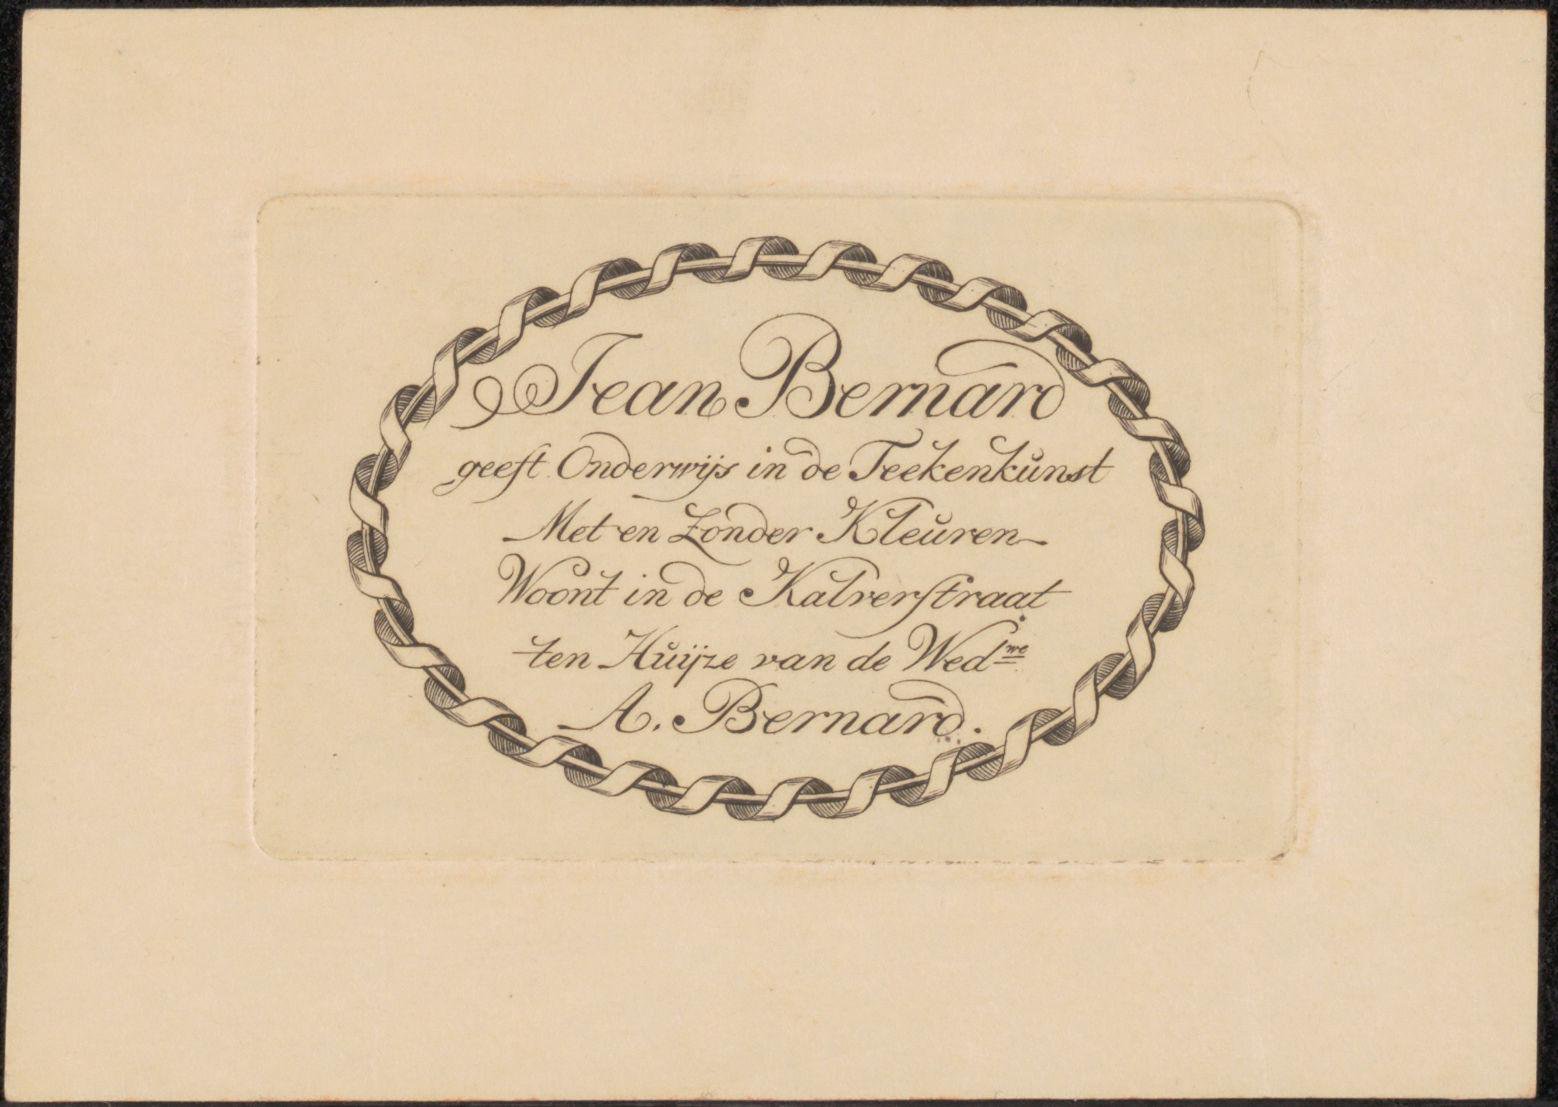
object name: business card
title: Adreskaart van Jean Bernard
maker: jean bernard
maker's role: draughtsman, print maker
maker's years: 1765-1833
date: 1775-1833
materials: cardboard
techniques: printing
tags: drawing, education, tuition of the artist (in general)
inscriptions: collector's mark: Lugt 2228